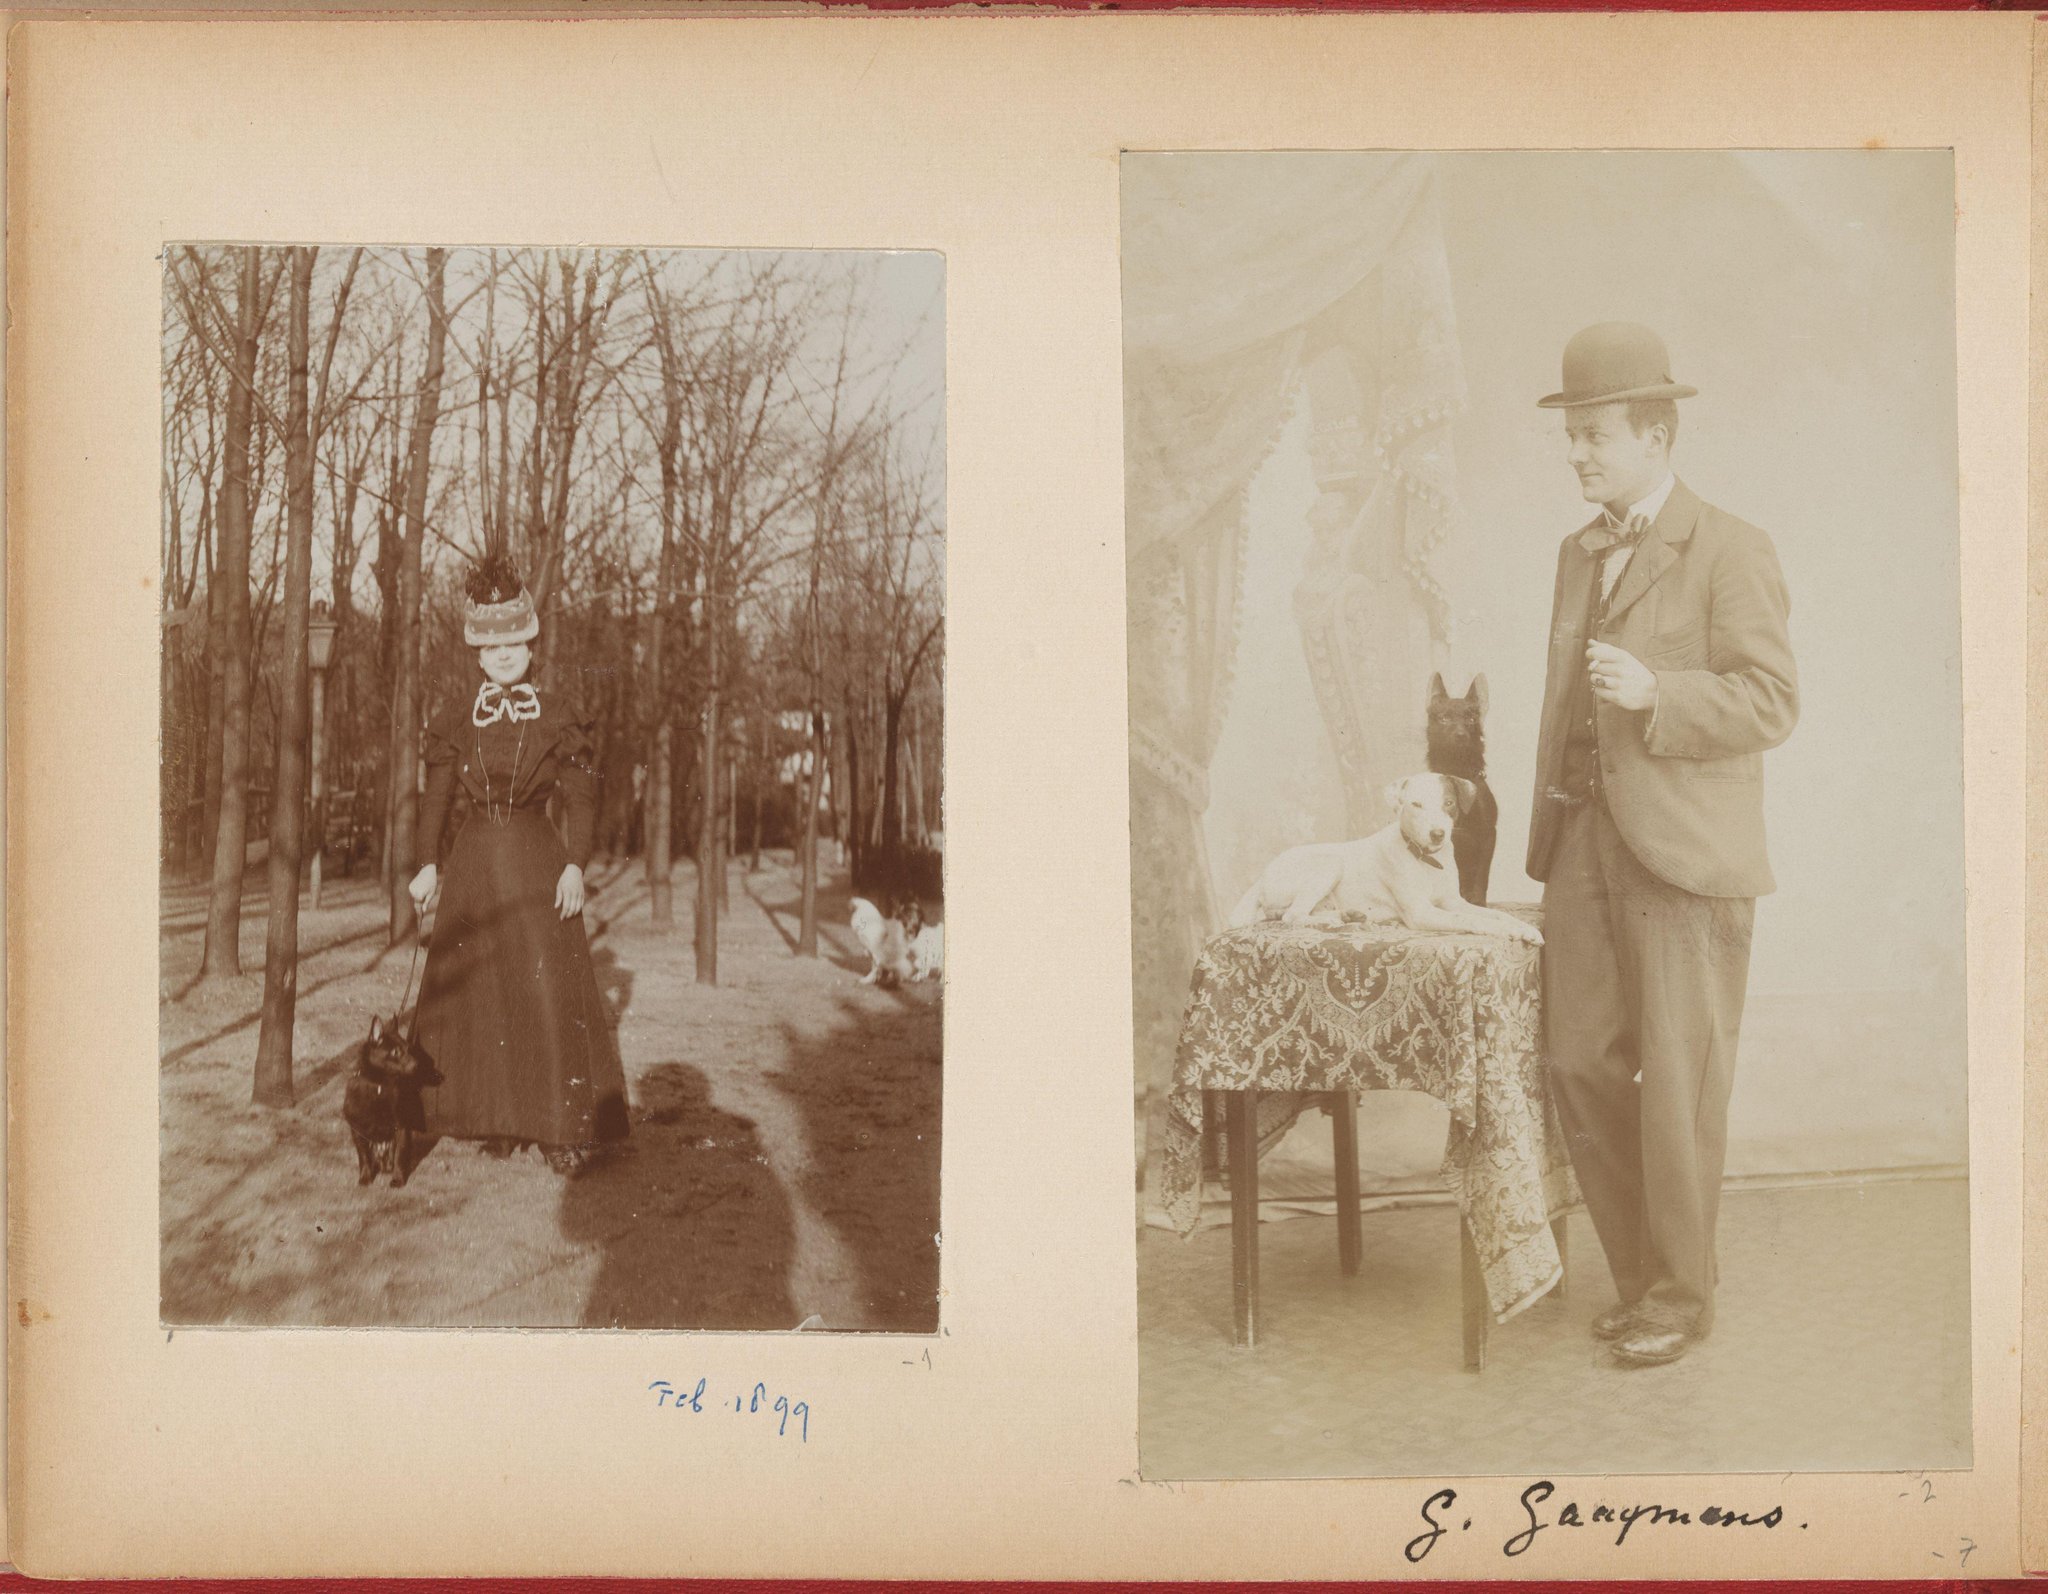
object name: photograph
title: Portret van G. Gaaymans met op de tafel de honden Tom en Fritsje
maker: gerard aalbersberg (us)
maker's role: amateurfotograaf, arts, chirurg, gynaecoloog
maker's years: 1870-1934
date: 1802-1899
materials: paper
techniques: collodion silver print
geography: amsterdam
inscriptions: date: ‘feb 1899’